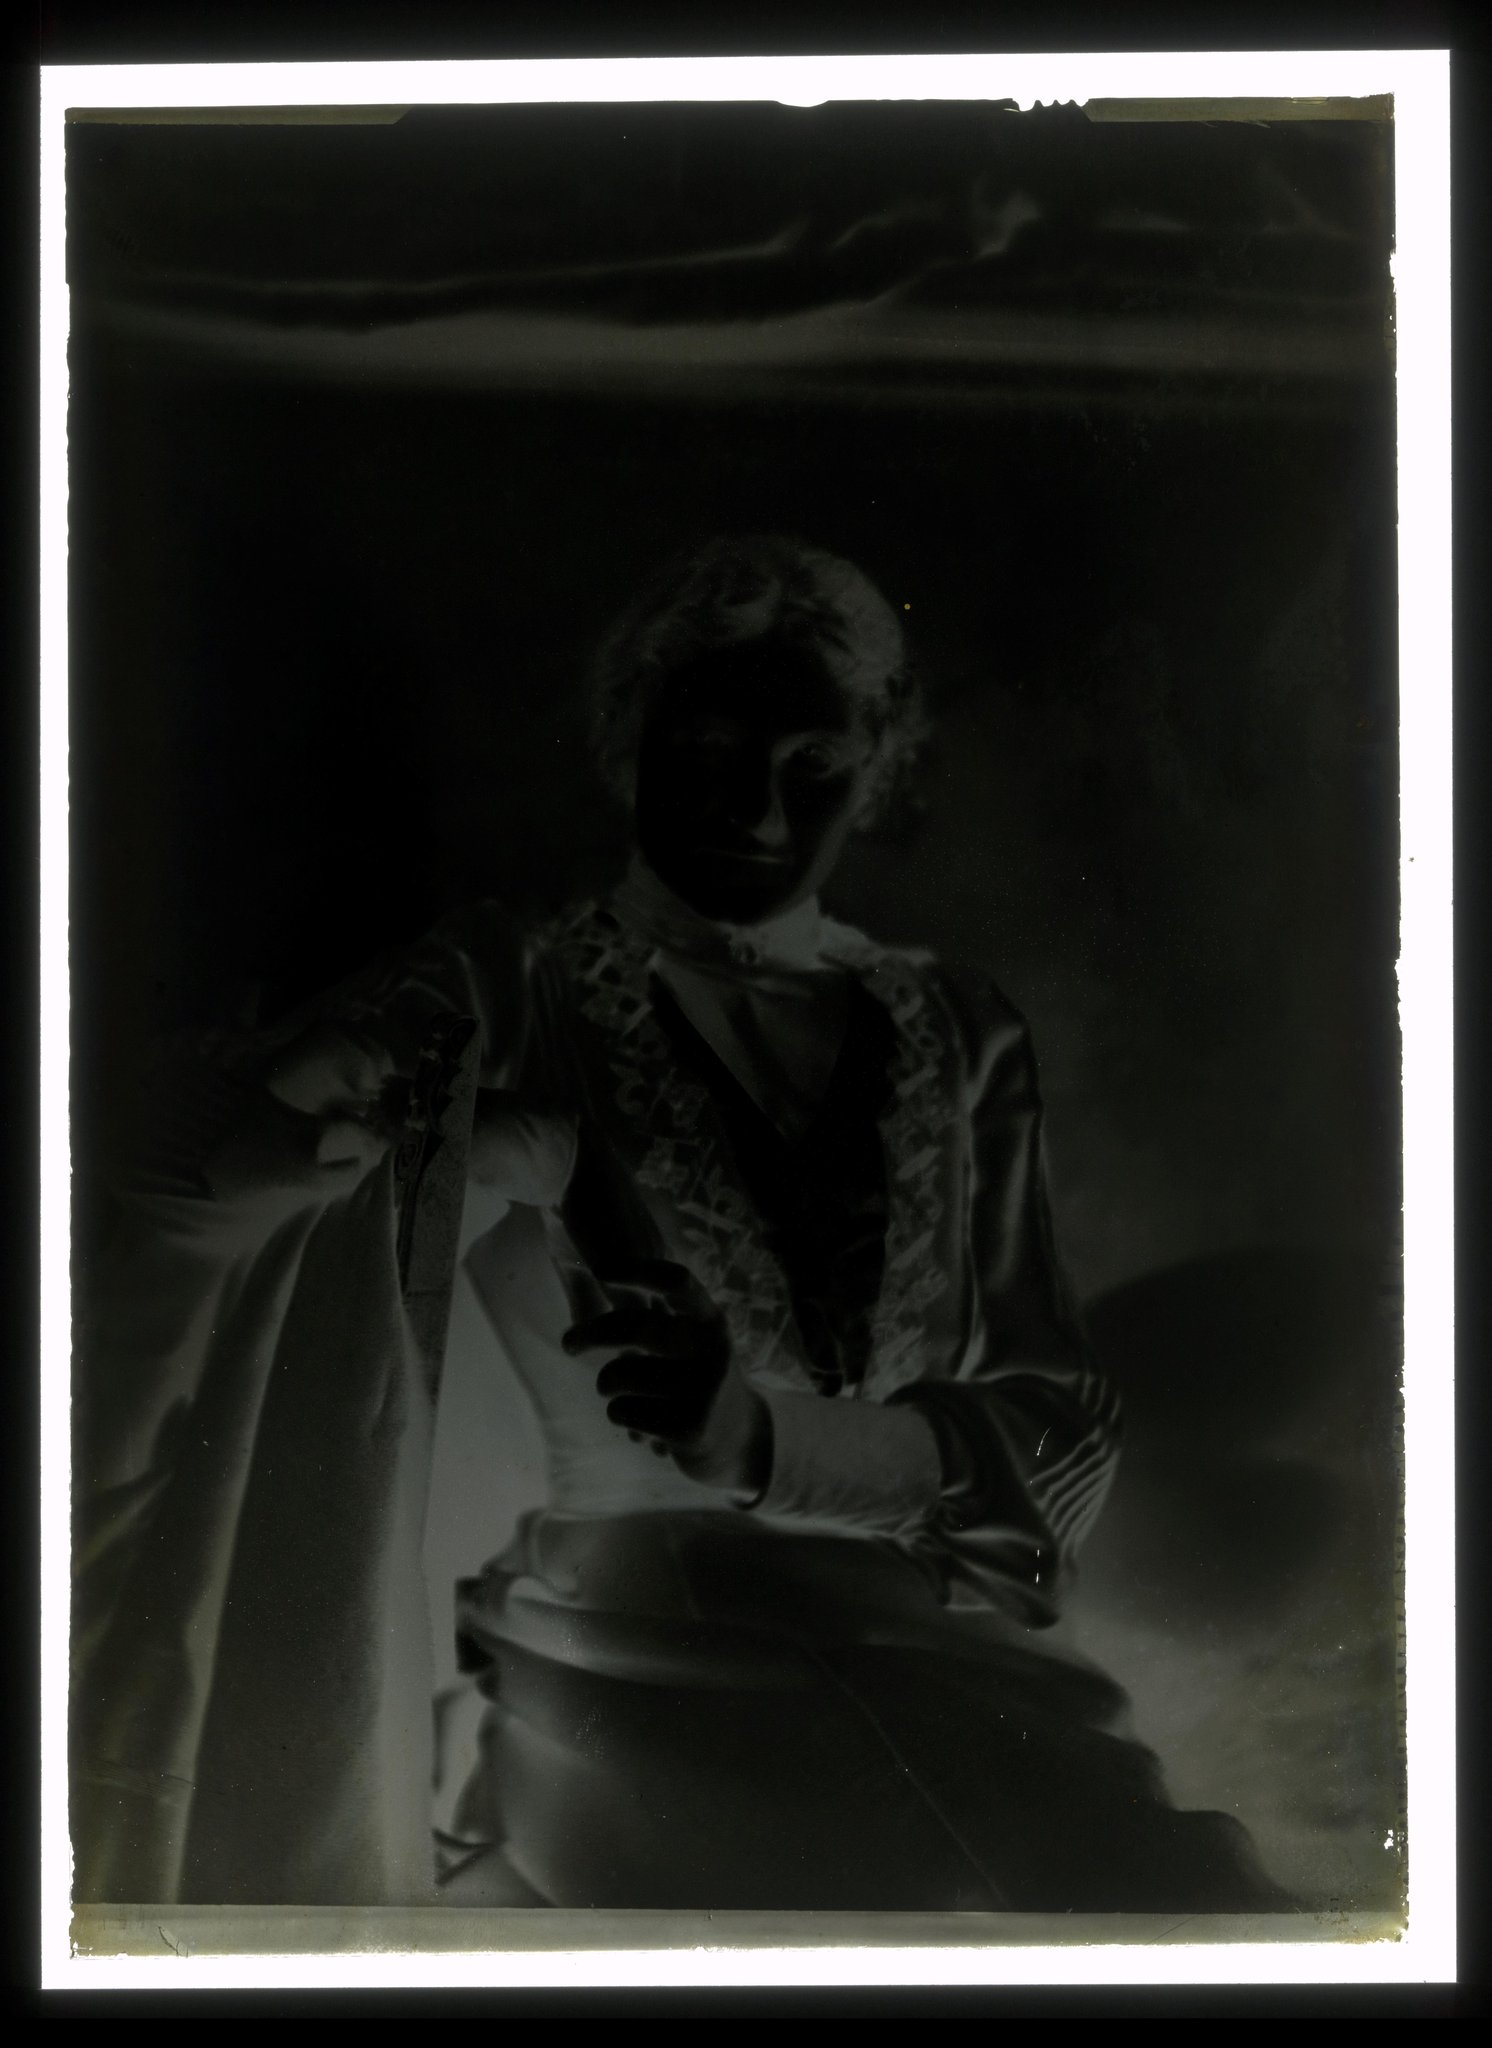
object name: glasnegatief, glasplaatnegatief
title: Portret van een onbekende vrouw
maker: laurens lodewijk kleijn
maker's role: draughtsman, painter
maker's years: 1826-1909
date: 1865-1900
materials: glass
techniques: collodion process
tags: anonymous historical person portrayed - bb - woman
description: Onderdeel van een groep glasnegatieven uit de nalatenschap van de schilder Laurens Lodewijk Kleijn, met stillevens, portretten, zelfportretten en kunstreproducties.